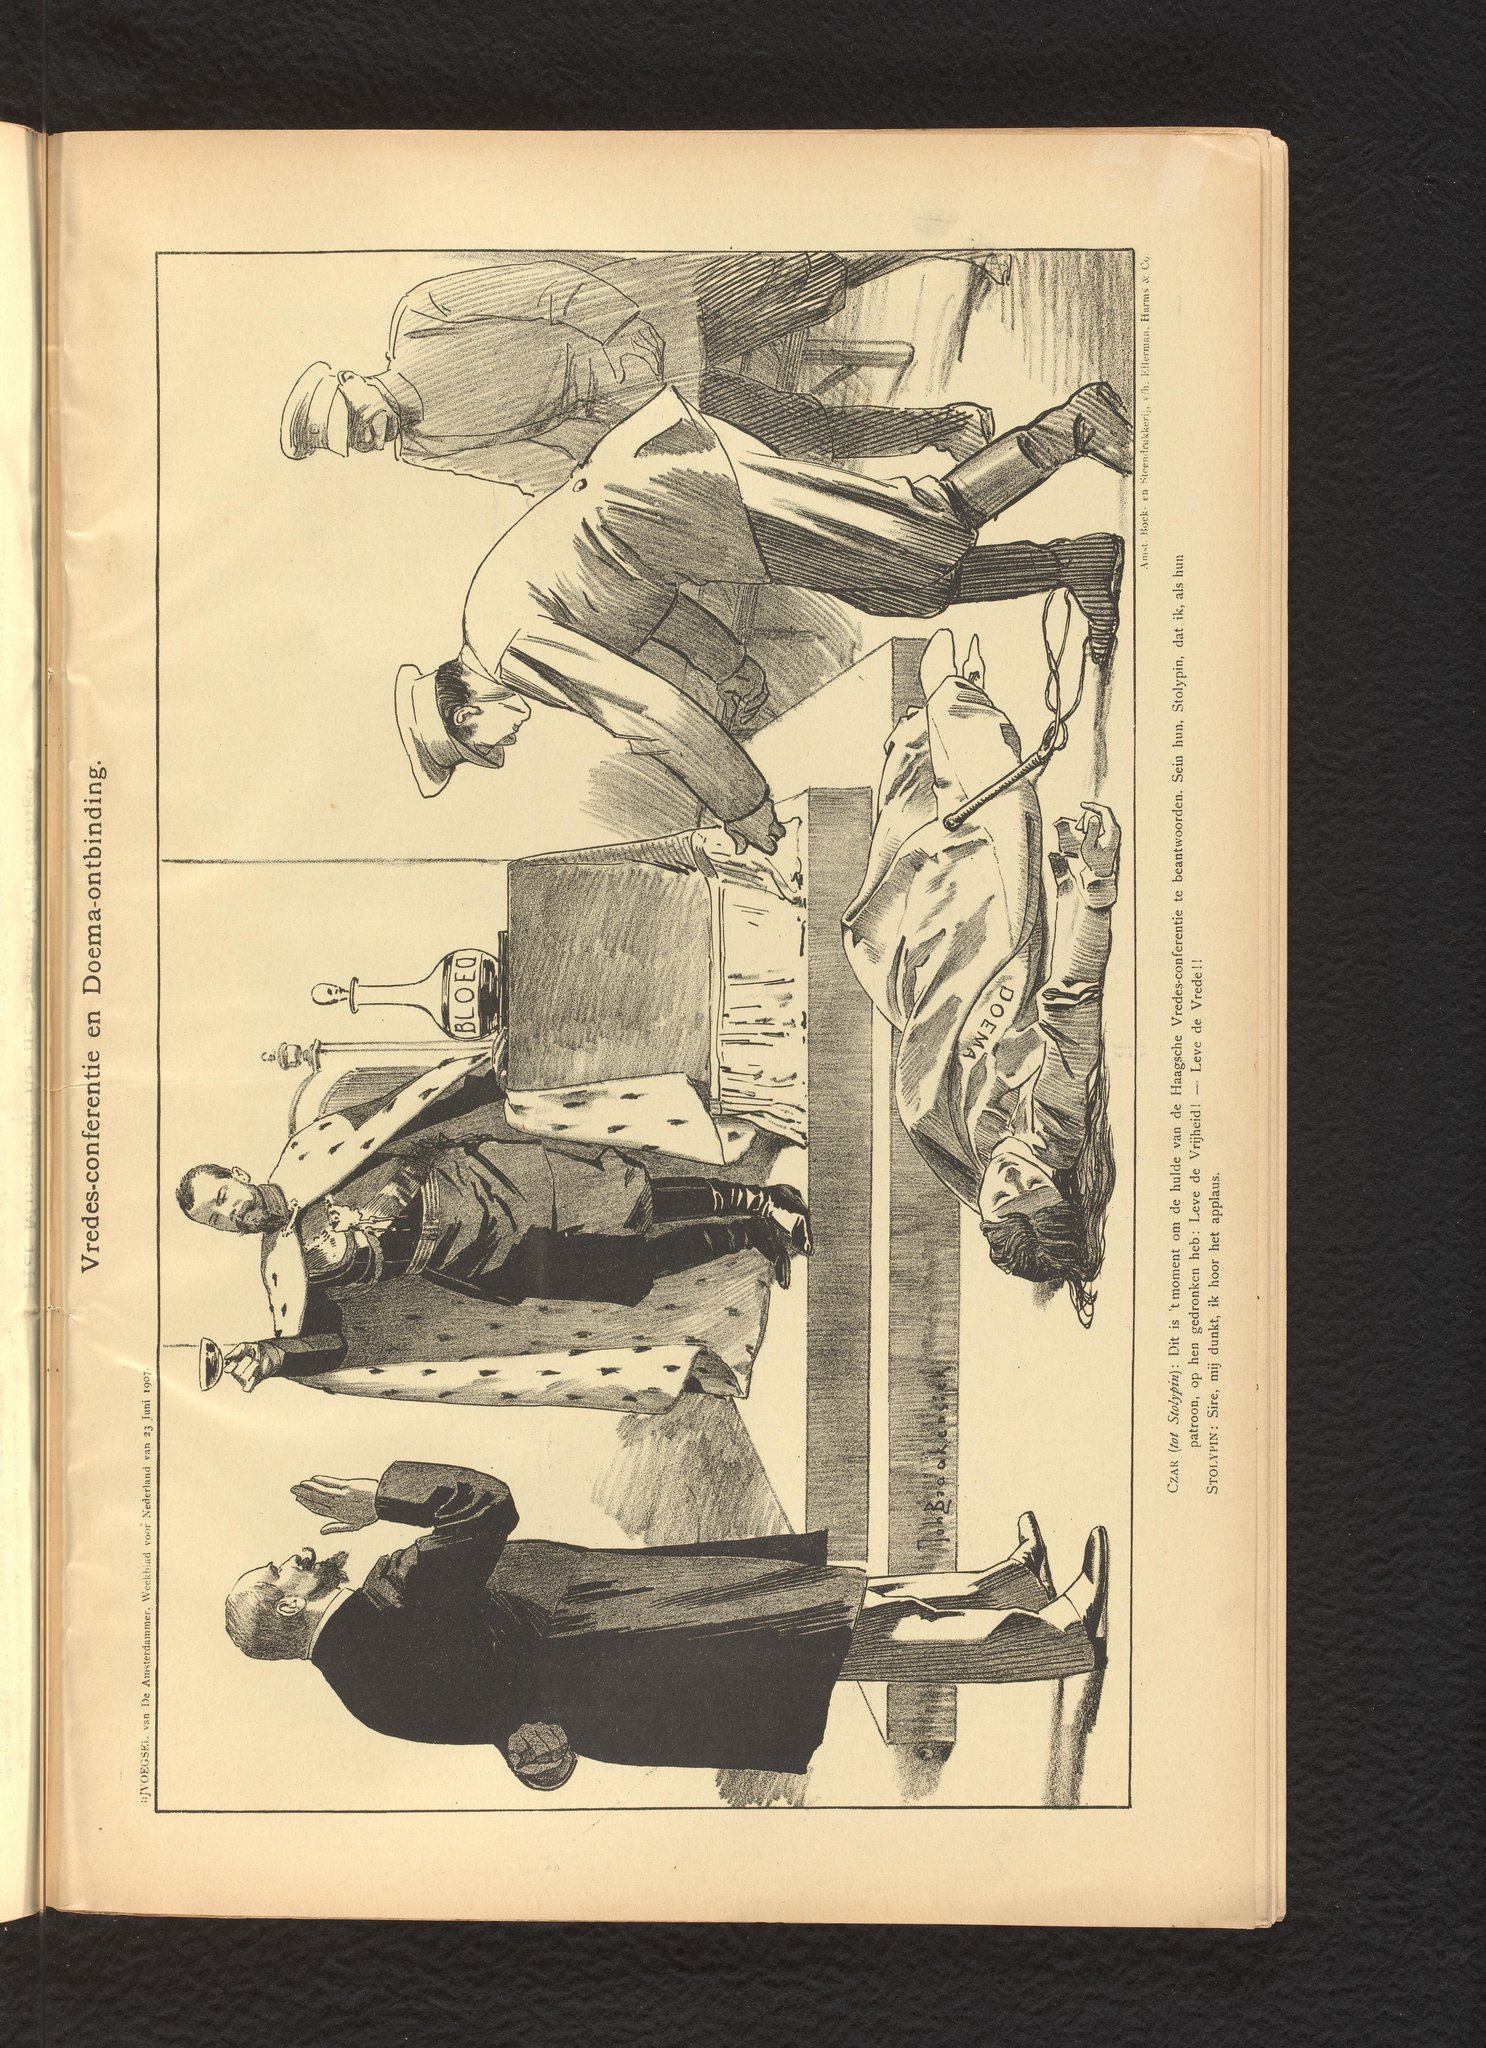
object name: cartoon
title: Vredes-conferentie en Doema-ontbinding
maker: johan braakensiek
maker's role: draughtsman, print maker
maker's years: 1858-1940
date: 1907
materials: paper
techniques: lithograph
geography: netherlands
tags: banquet of elegant company (+ toast at meal, banquet), drinking, lower house, parliament, chamber, political caricatures and satires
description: De Russische tsaar Nicolaas II heft het glas - met bloed - naar zijn premier Stolypin op de Tweede Haagse vredesconferentie en na het ontbinden van de Doema, het Russische parlement. Twee soldaten komen om het lichaam van de Doema af te voeren.